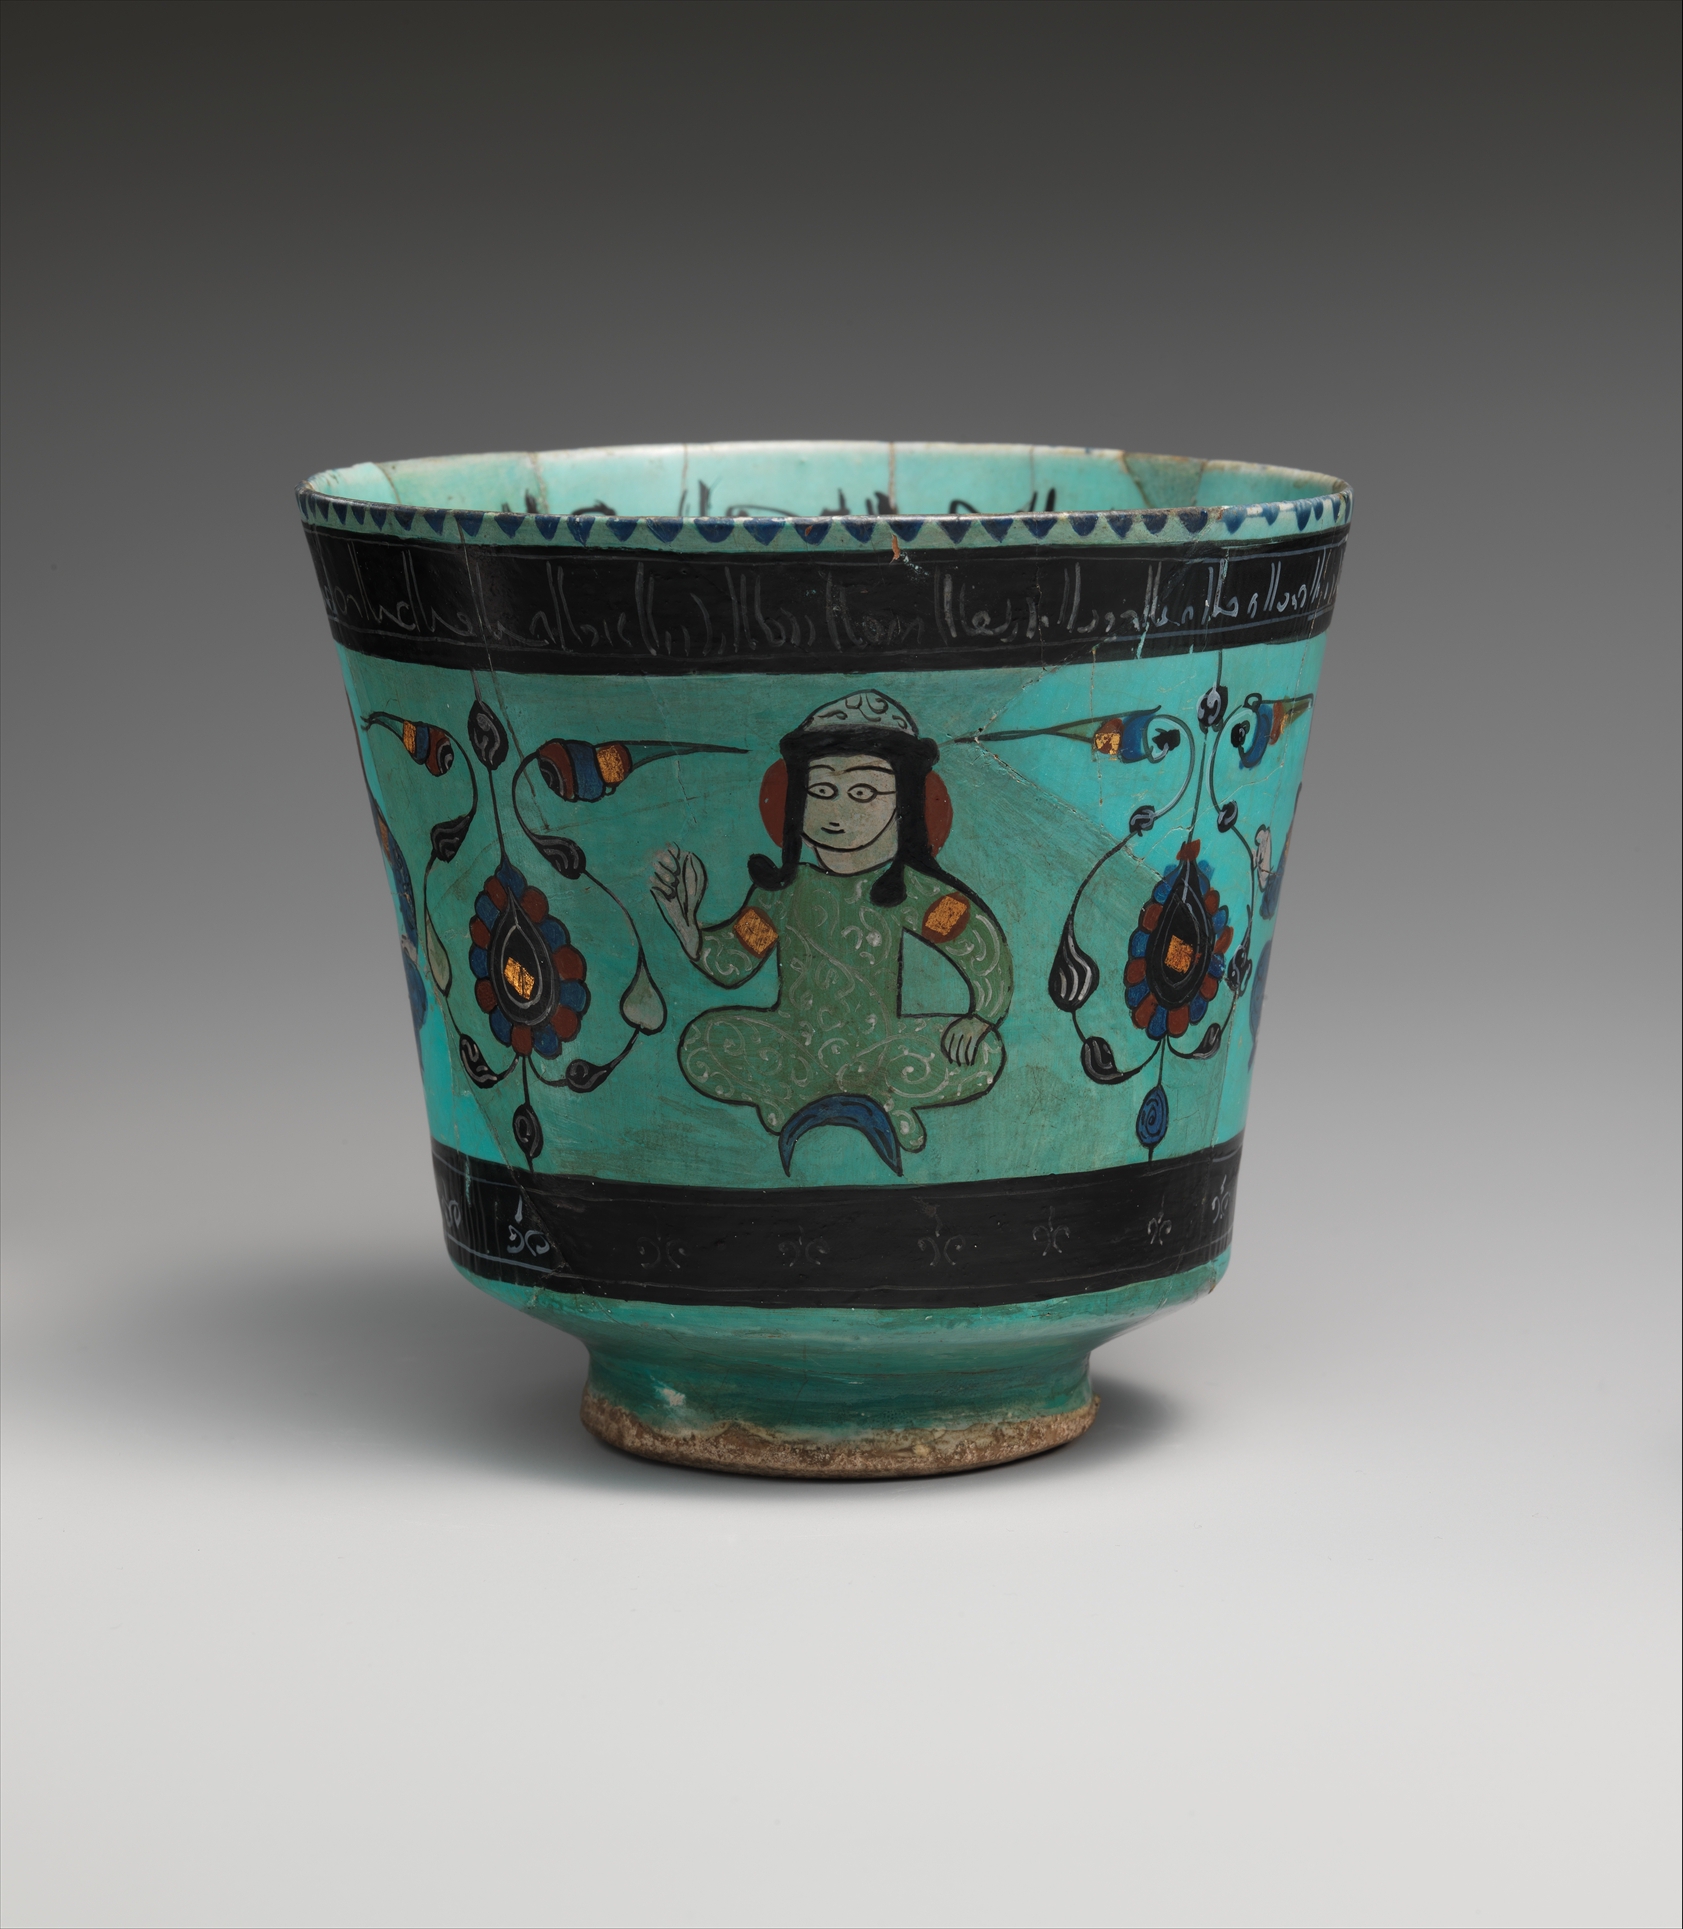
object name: beaker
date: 1101-1300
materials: stonepaste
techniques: overglaze, painting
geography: iran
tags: men